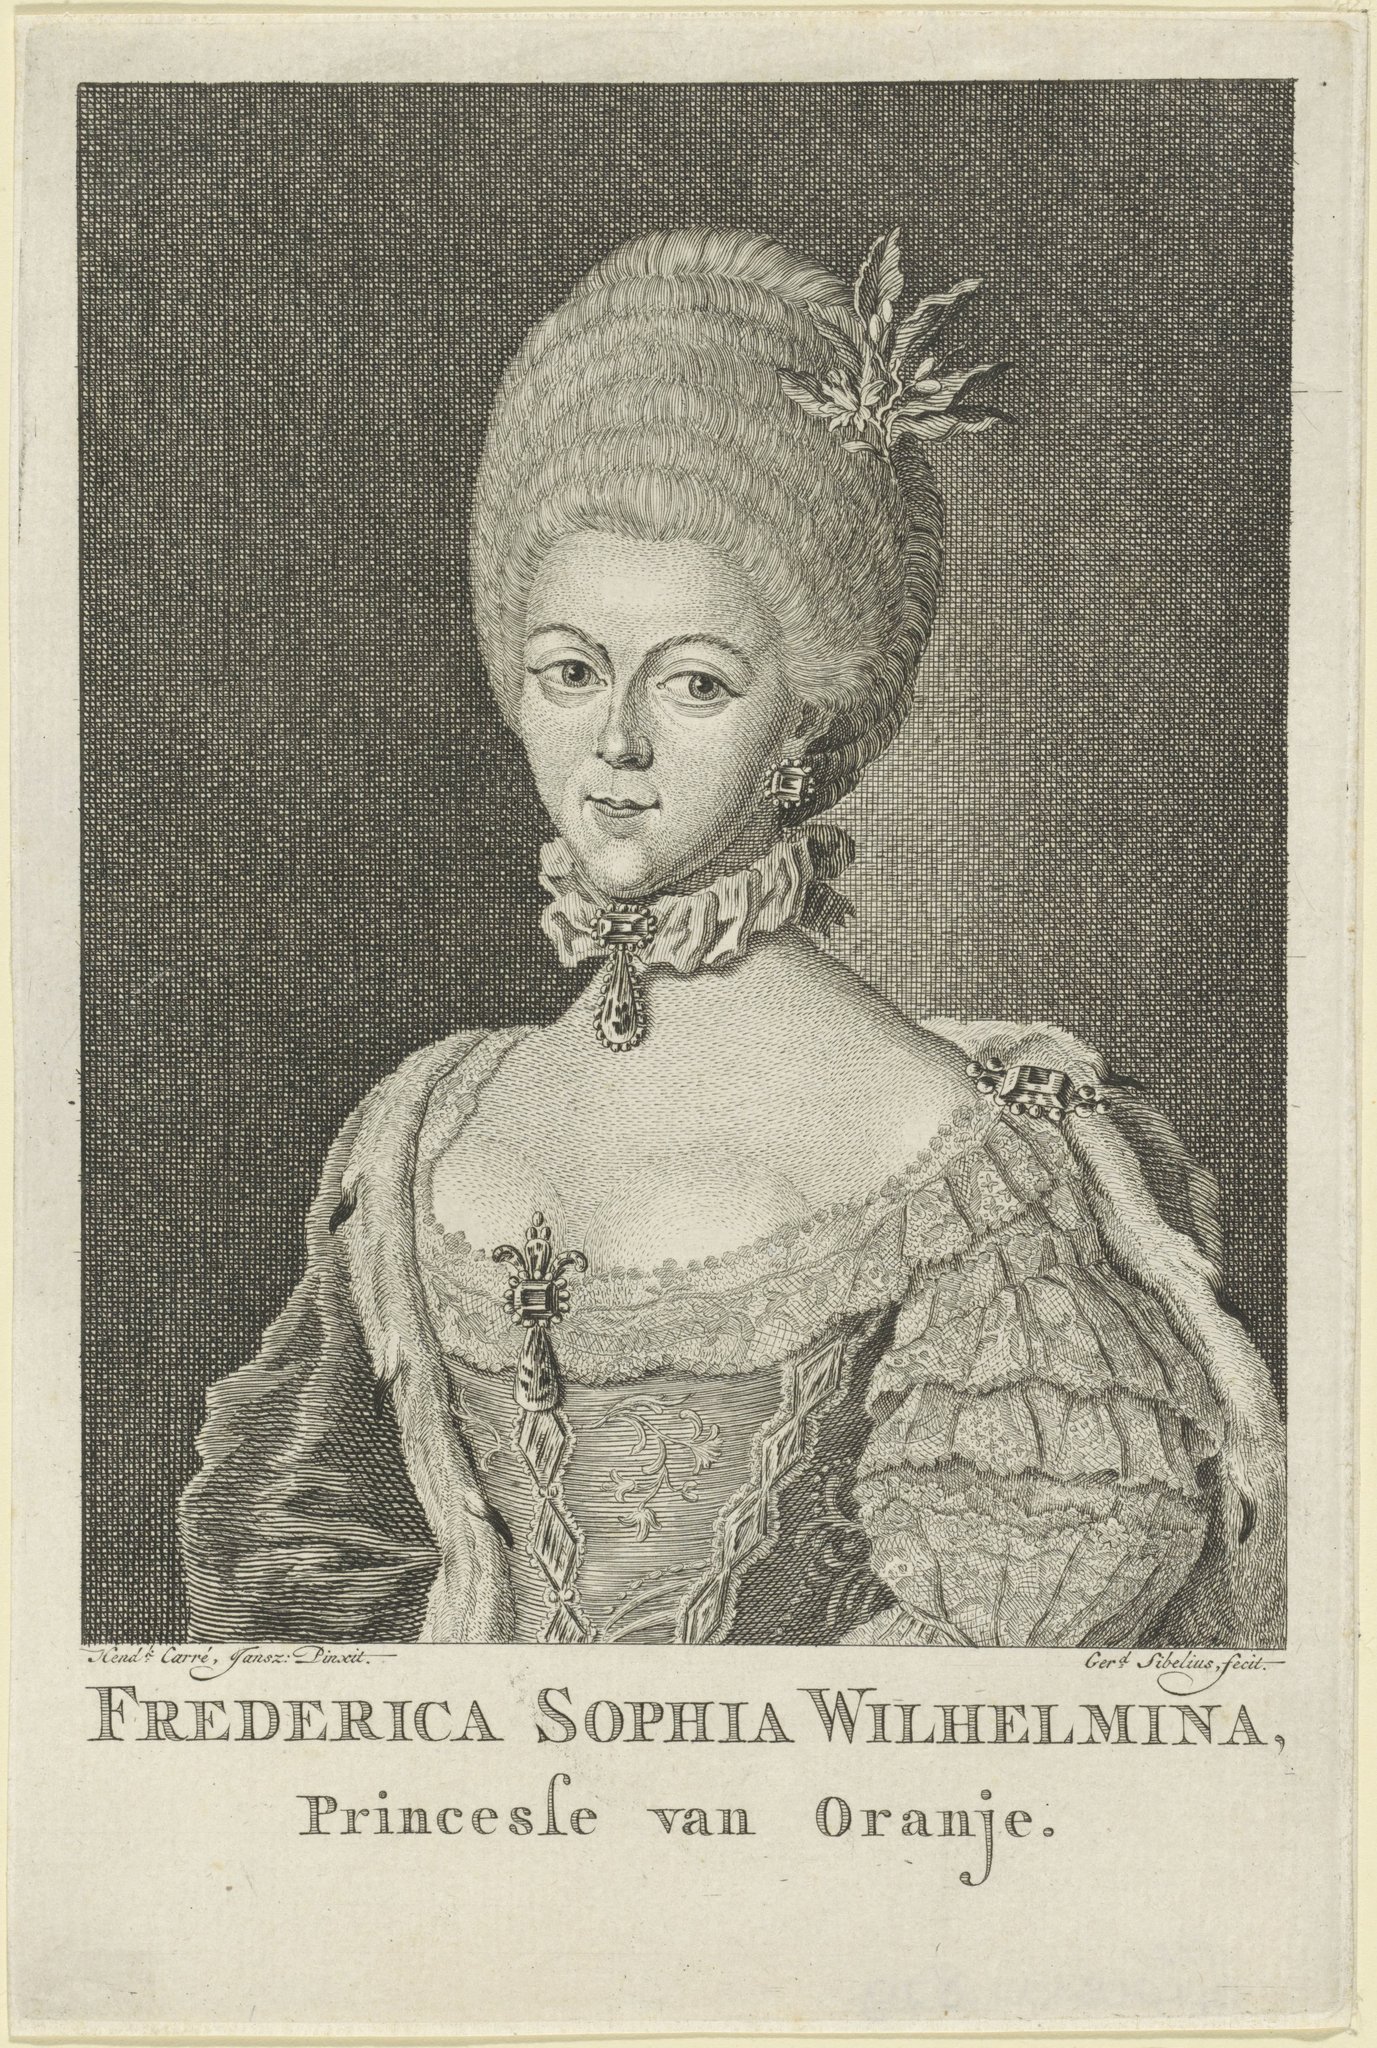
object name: print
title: Portret van Wilhelmina van Pruisen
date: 1767-1785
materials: paper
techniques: engraving, etching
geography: northern netherlands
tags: painter, draughtsman, wilhelmina of prussia (princess of orange)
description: Portret van Wilhelmina. In de ondermarge haar naam en titel.